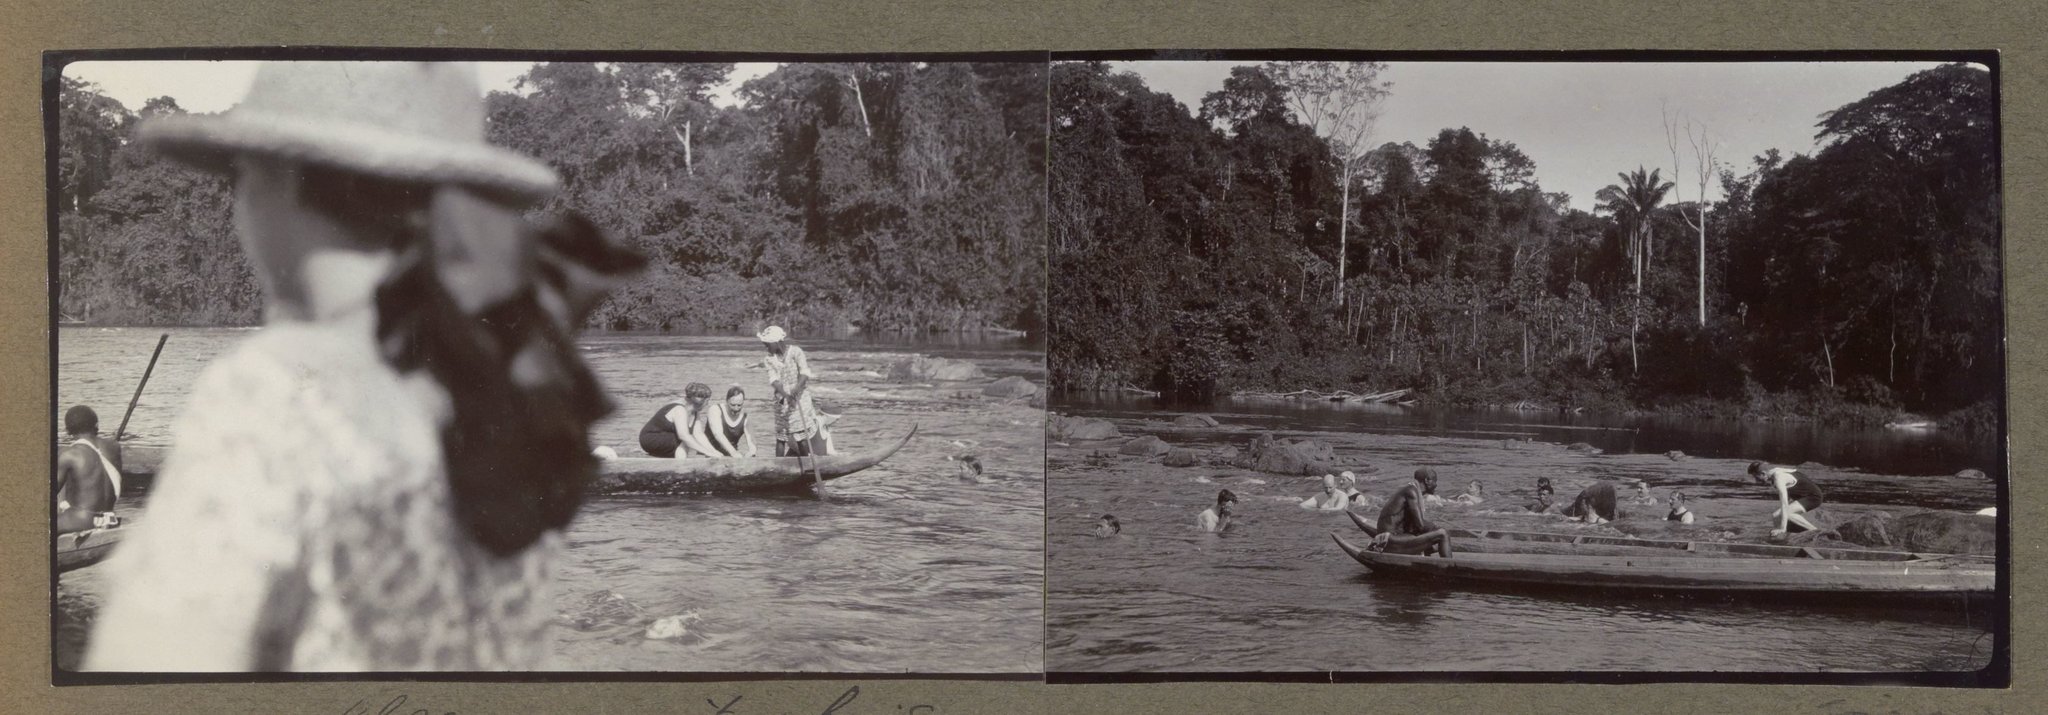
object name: panoramic photograph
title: Klaar voor 't bad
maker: Anonymous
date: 1920-1930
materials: photographic support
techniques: gelatin silver print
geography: suriname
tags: swimming (sport), suriname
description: Panoramafoto bestaande uit twee afdrukken. Onderdeel van fotoalbum van een onbekende Nederlandse familie met opnames van Suriname, Europa en Nederlands-Indië.